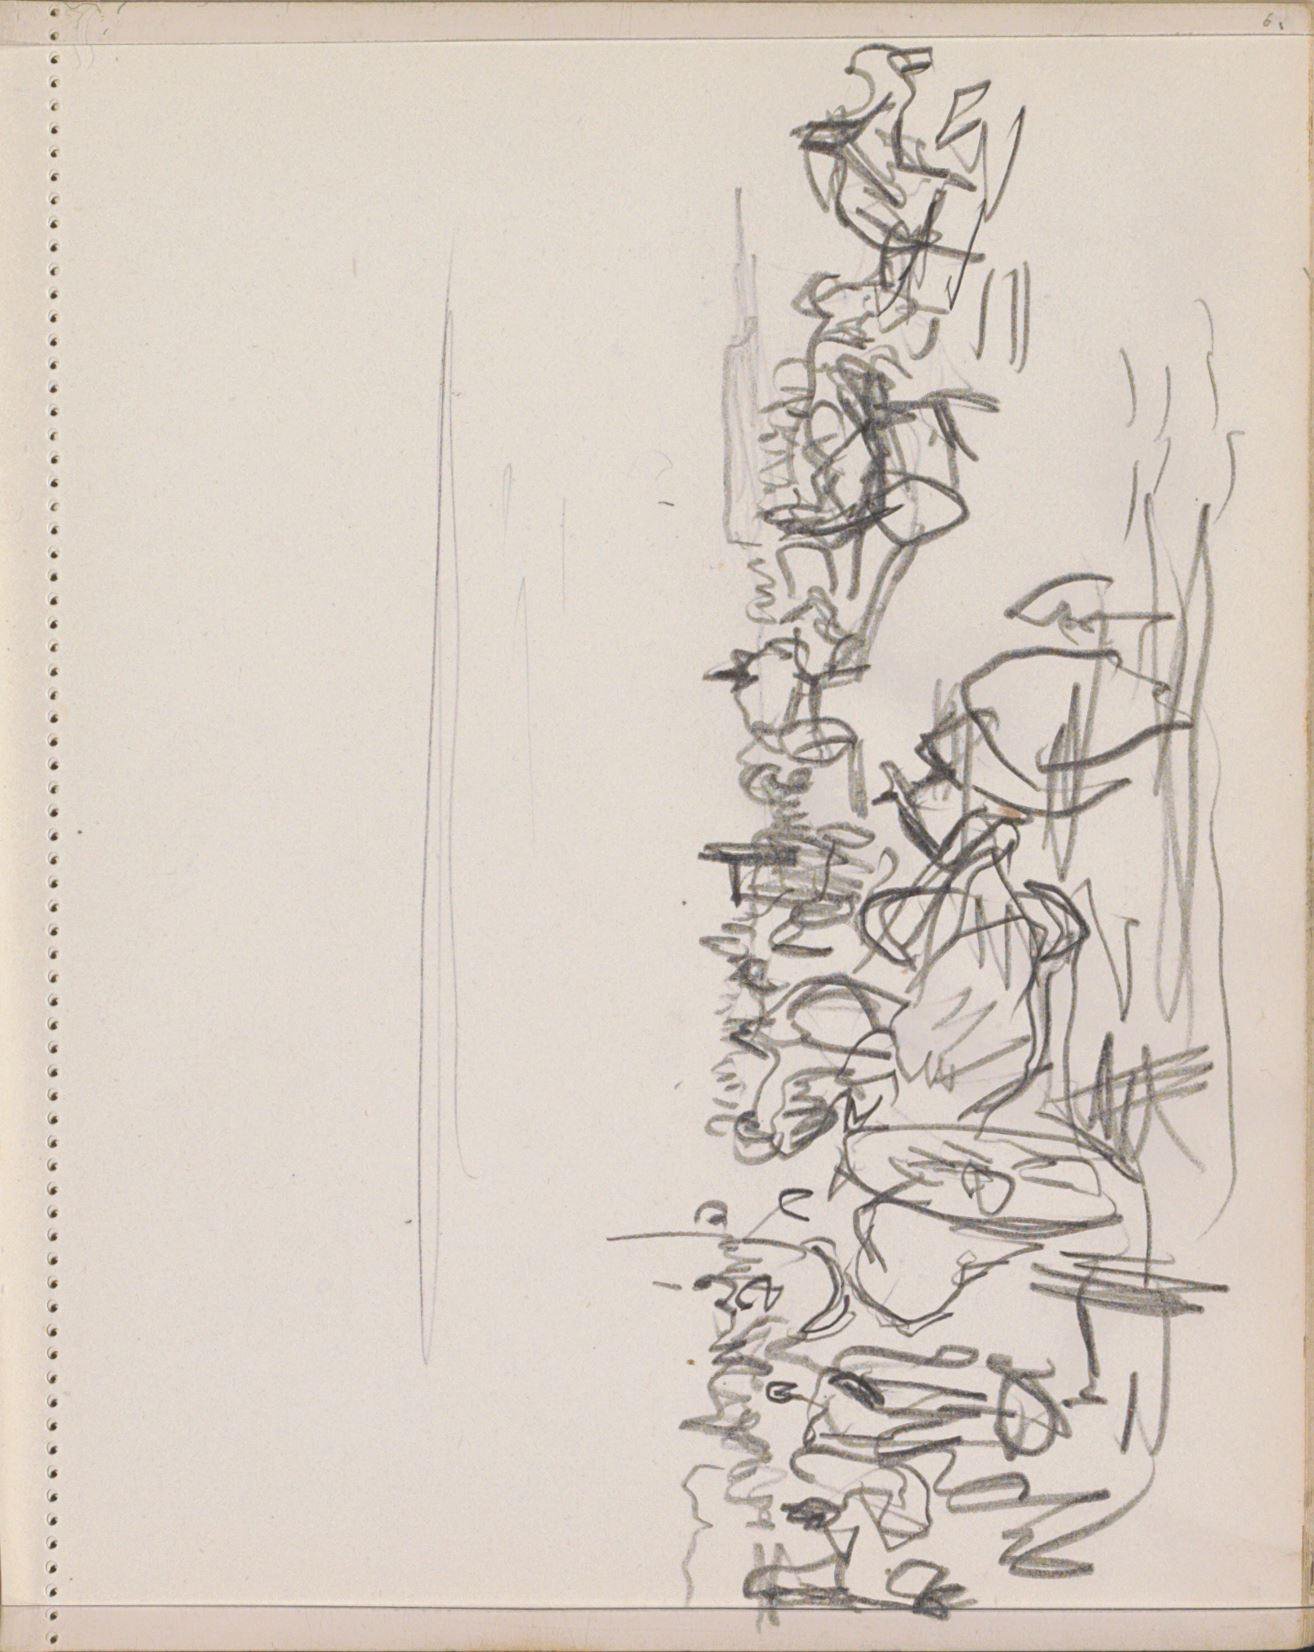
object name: sketchbook leaf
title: Weg met karren en figuren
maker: marius bauer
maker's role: draughtsman, print maker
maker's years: 1867-1932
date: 1924-1925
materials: paper, pencil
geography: india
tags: road, path, (farm) wagon, freight wagon, cart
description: Pagina 61 uit een schetsboek met 75 bladen.